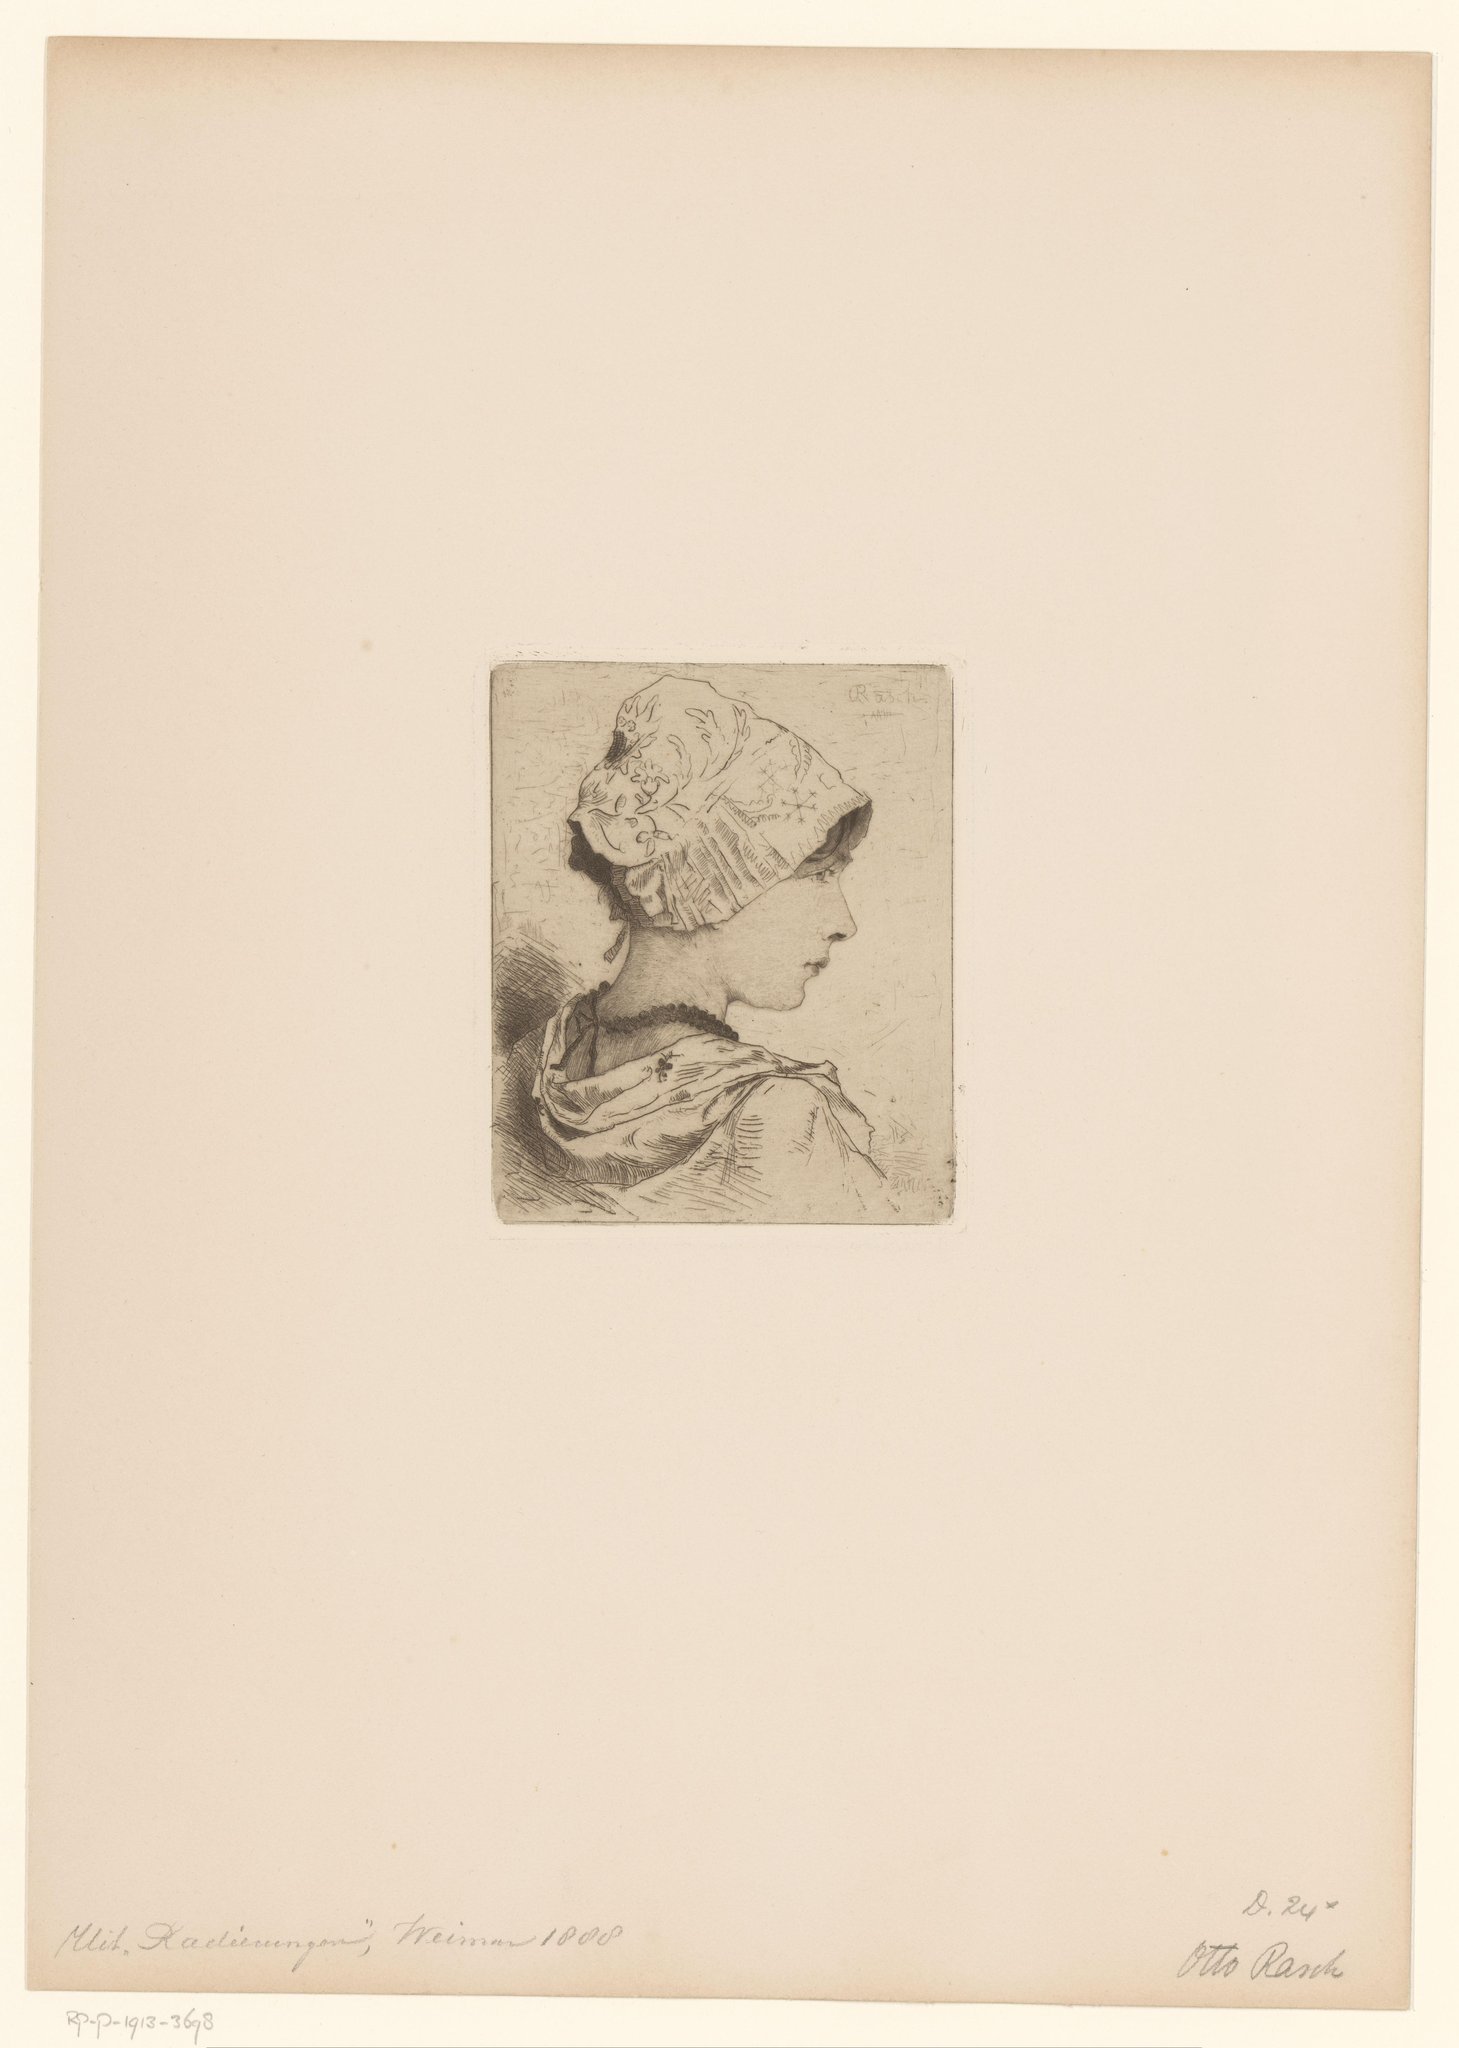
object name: print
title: Kop van een jonge vrouw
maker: otto rasch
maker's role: print maker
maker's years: 1862-1952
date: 1888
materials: paper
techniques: drypoint, etching, intaglio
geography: weimar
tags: adolescent, young woman, maiden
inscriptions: collector's mark: Lugt 2228, : ‘Uit "Radierungen" 1888’